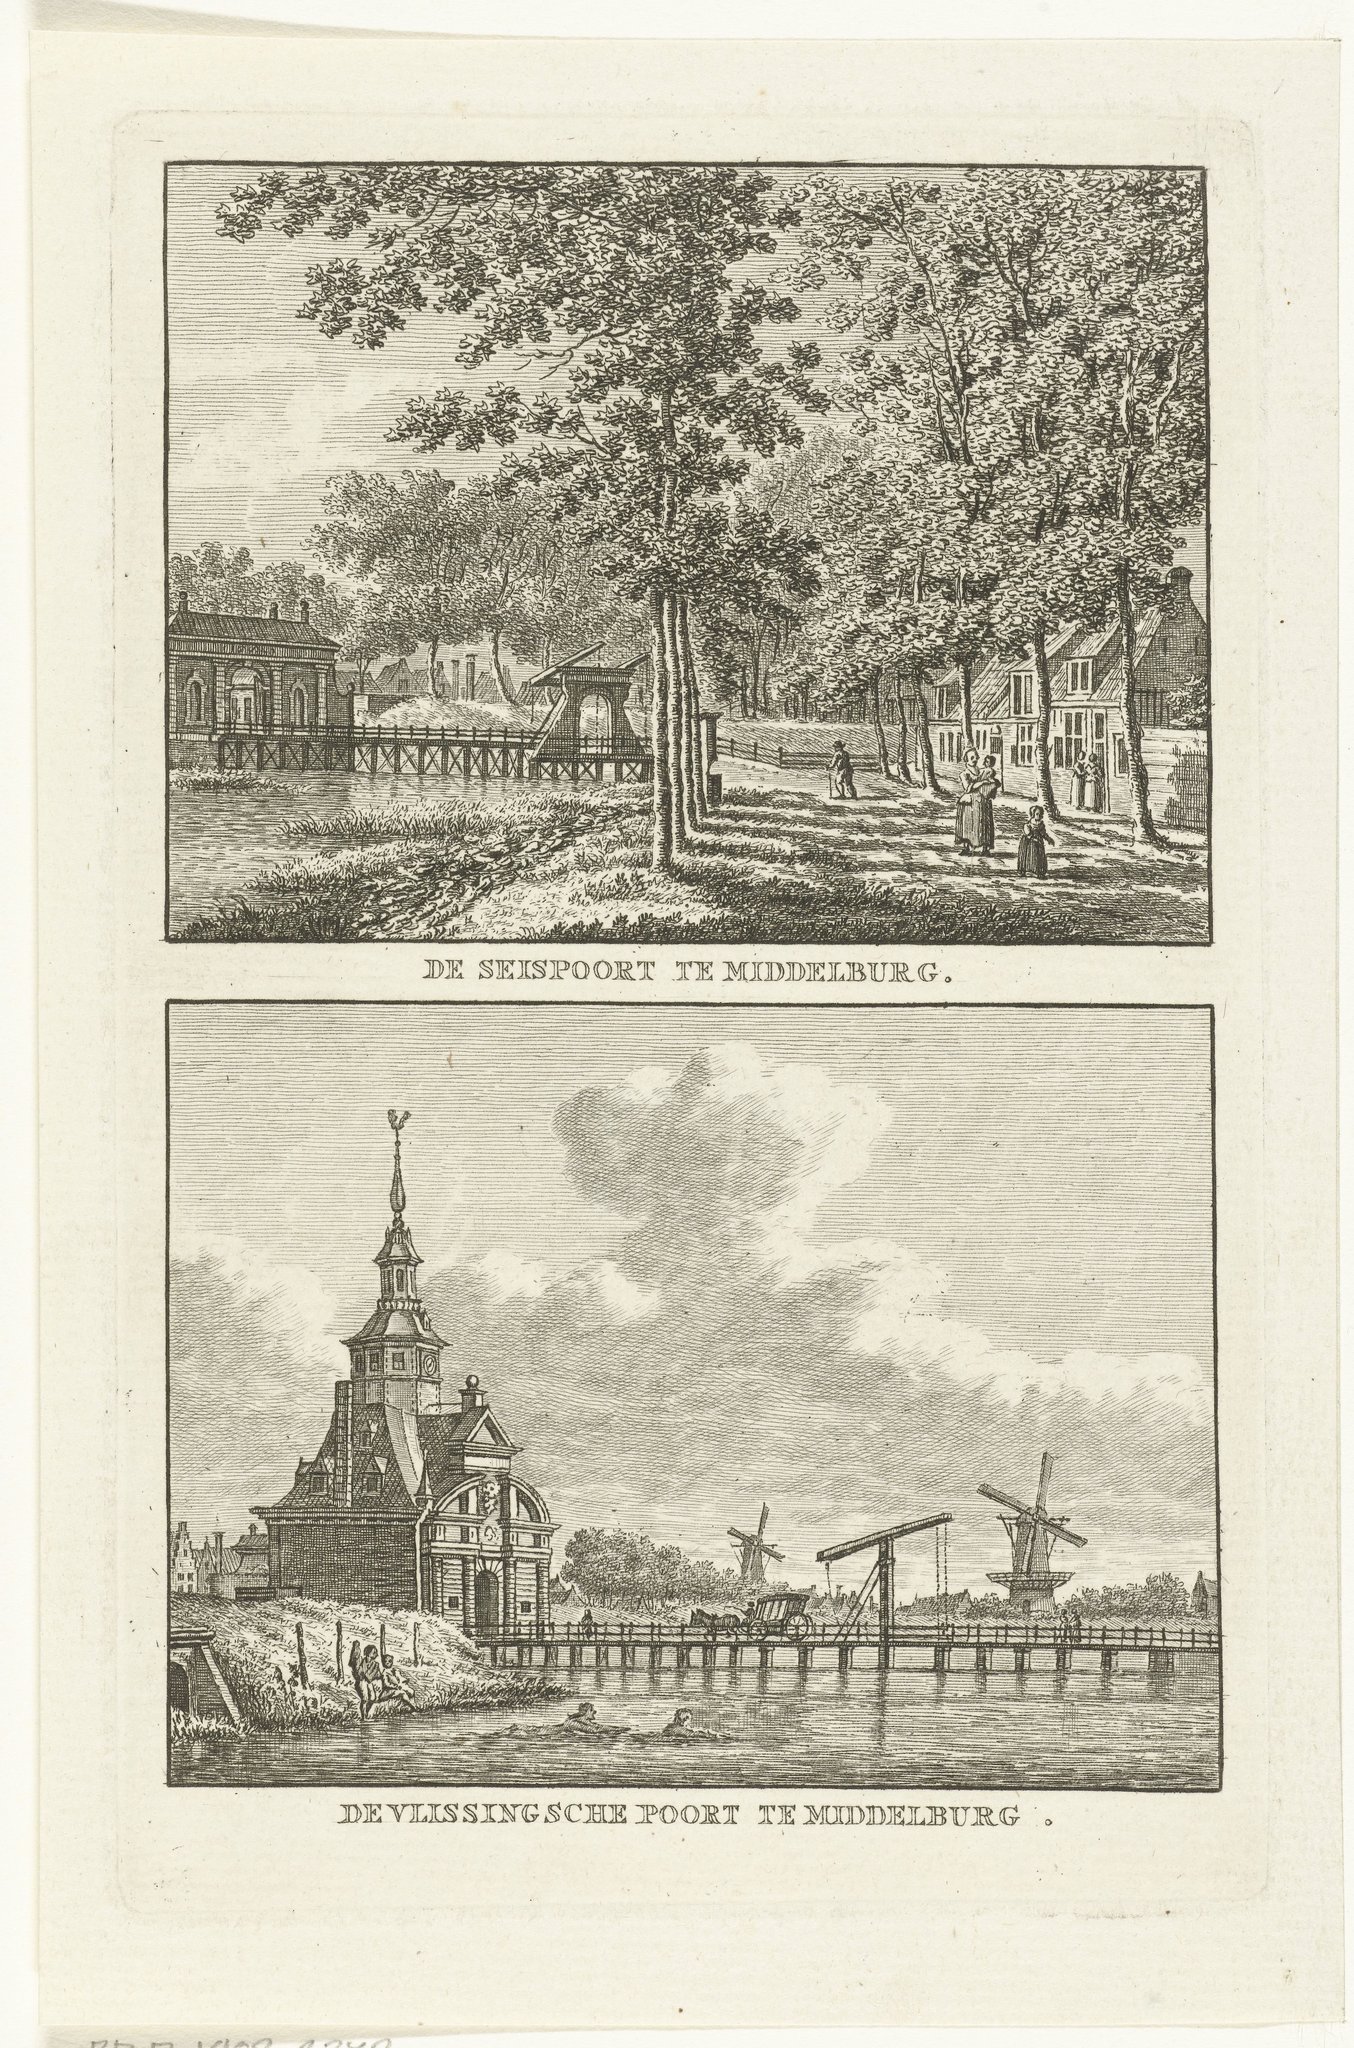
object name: print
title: De Seispoort te Middelburg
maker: carel frederik bendorp (i)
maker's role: print maker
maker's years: 1736-1814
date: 1786-1792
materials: paper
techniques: etching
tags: city-gate, middelburg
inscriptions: collector's mark: Lugt 2228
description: Prent uit: Vaderlandsche gezichten, of afbeeldingen van den tegenwoordigen staat der Vereenigde Nederlanden (…). Amsterdam: Hendrik Gartman, Willem Vermandel en Jan Willem Smit, 1786-1792. Uitgegeven in afleveringen met ieder een eigen bifolium en inhoudsopgave. Alle prenten in deze publicatie zijn gegraveerd door Carel Frederik Bendorp (I) en, in de meeste gevallen, gebaseerd op tekeningen van Jan Bulthuis.